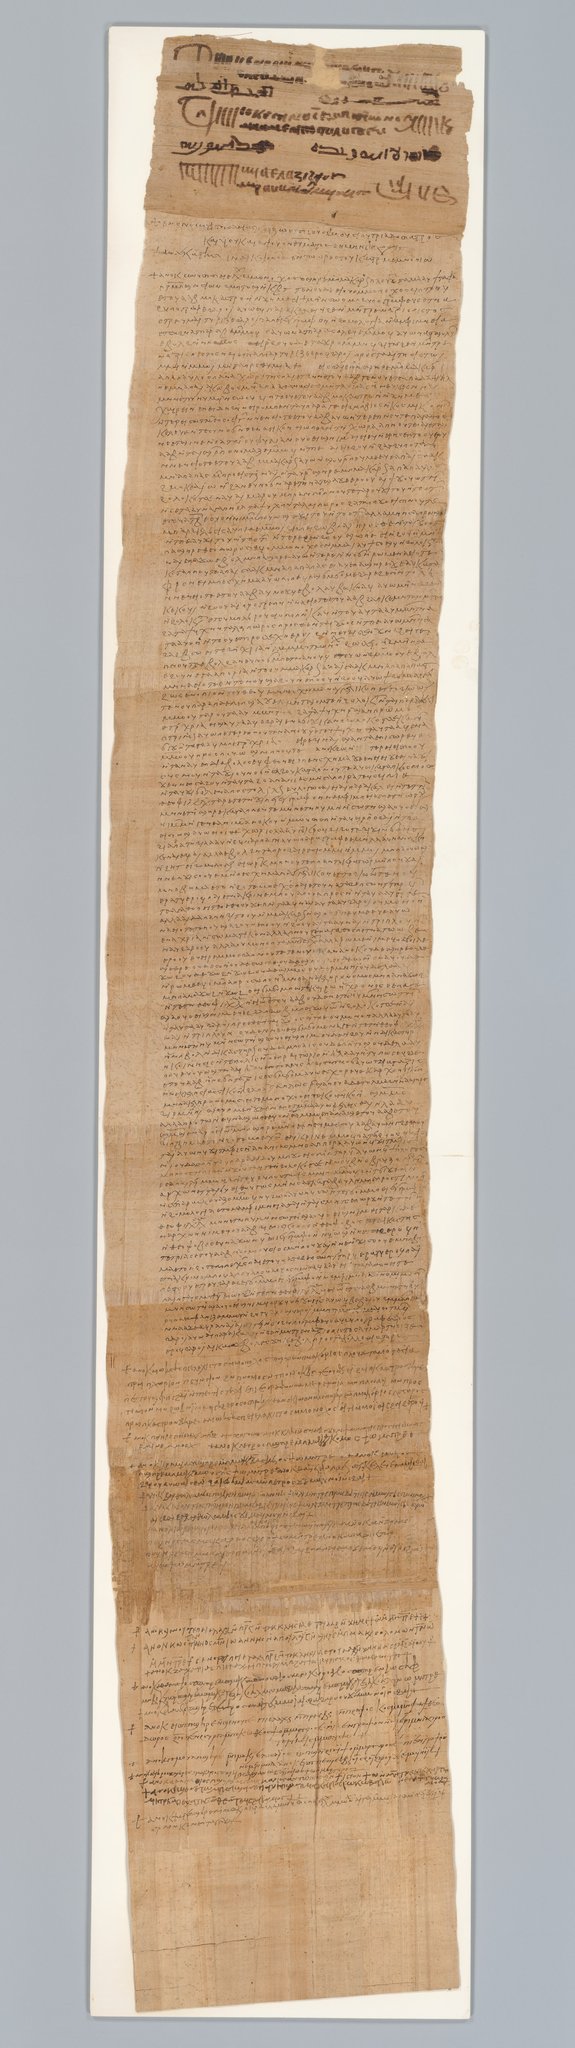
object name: papyrus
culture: coptic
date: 699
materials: ink, papyrus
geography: egypt